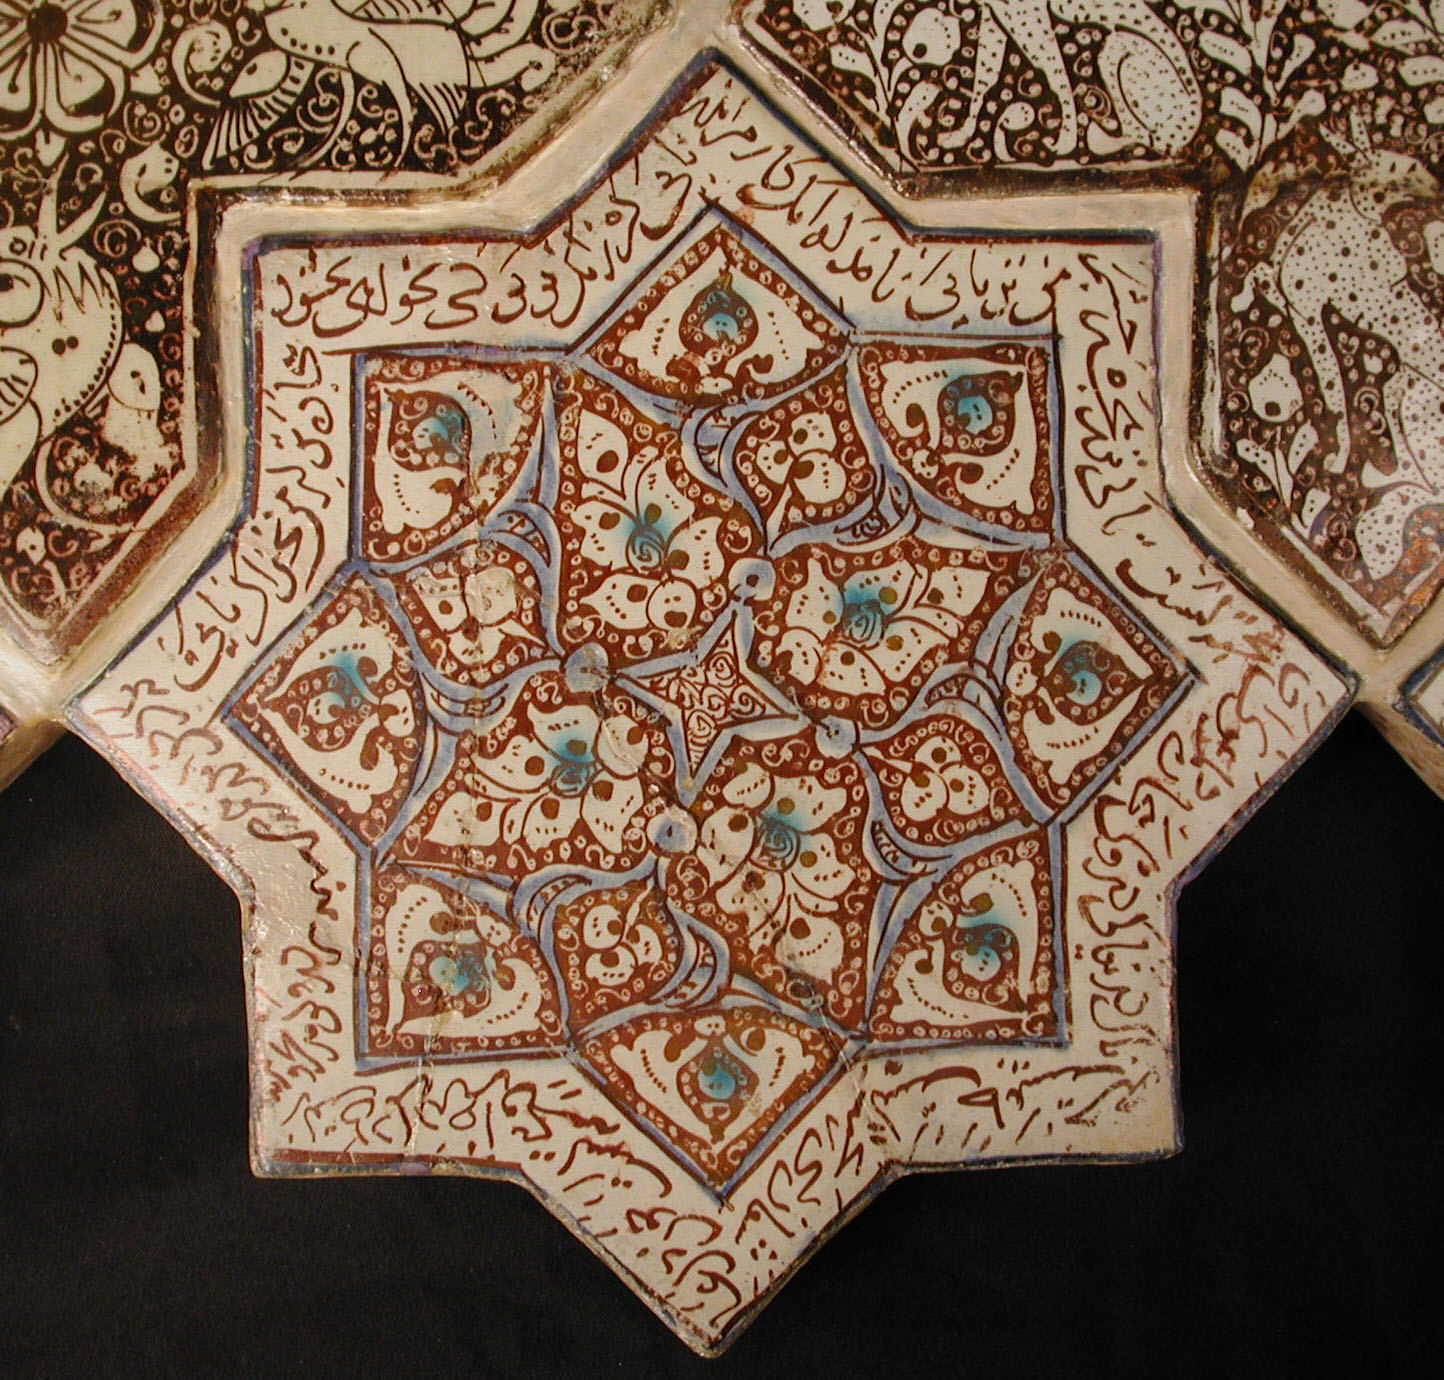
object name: tile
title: Star-Shaped Tile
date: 1201-1400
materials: glaze, stonepaste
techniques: luster painting, painting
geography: iran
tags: poetry,stars